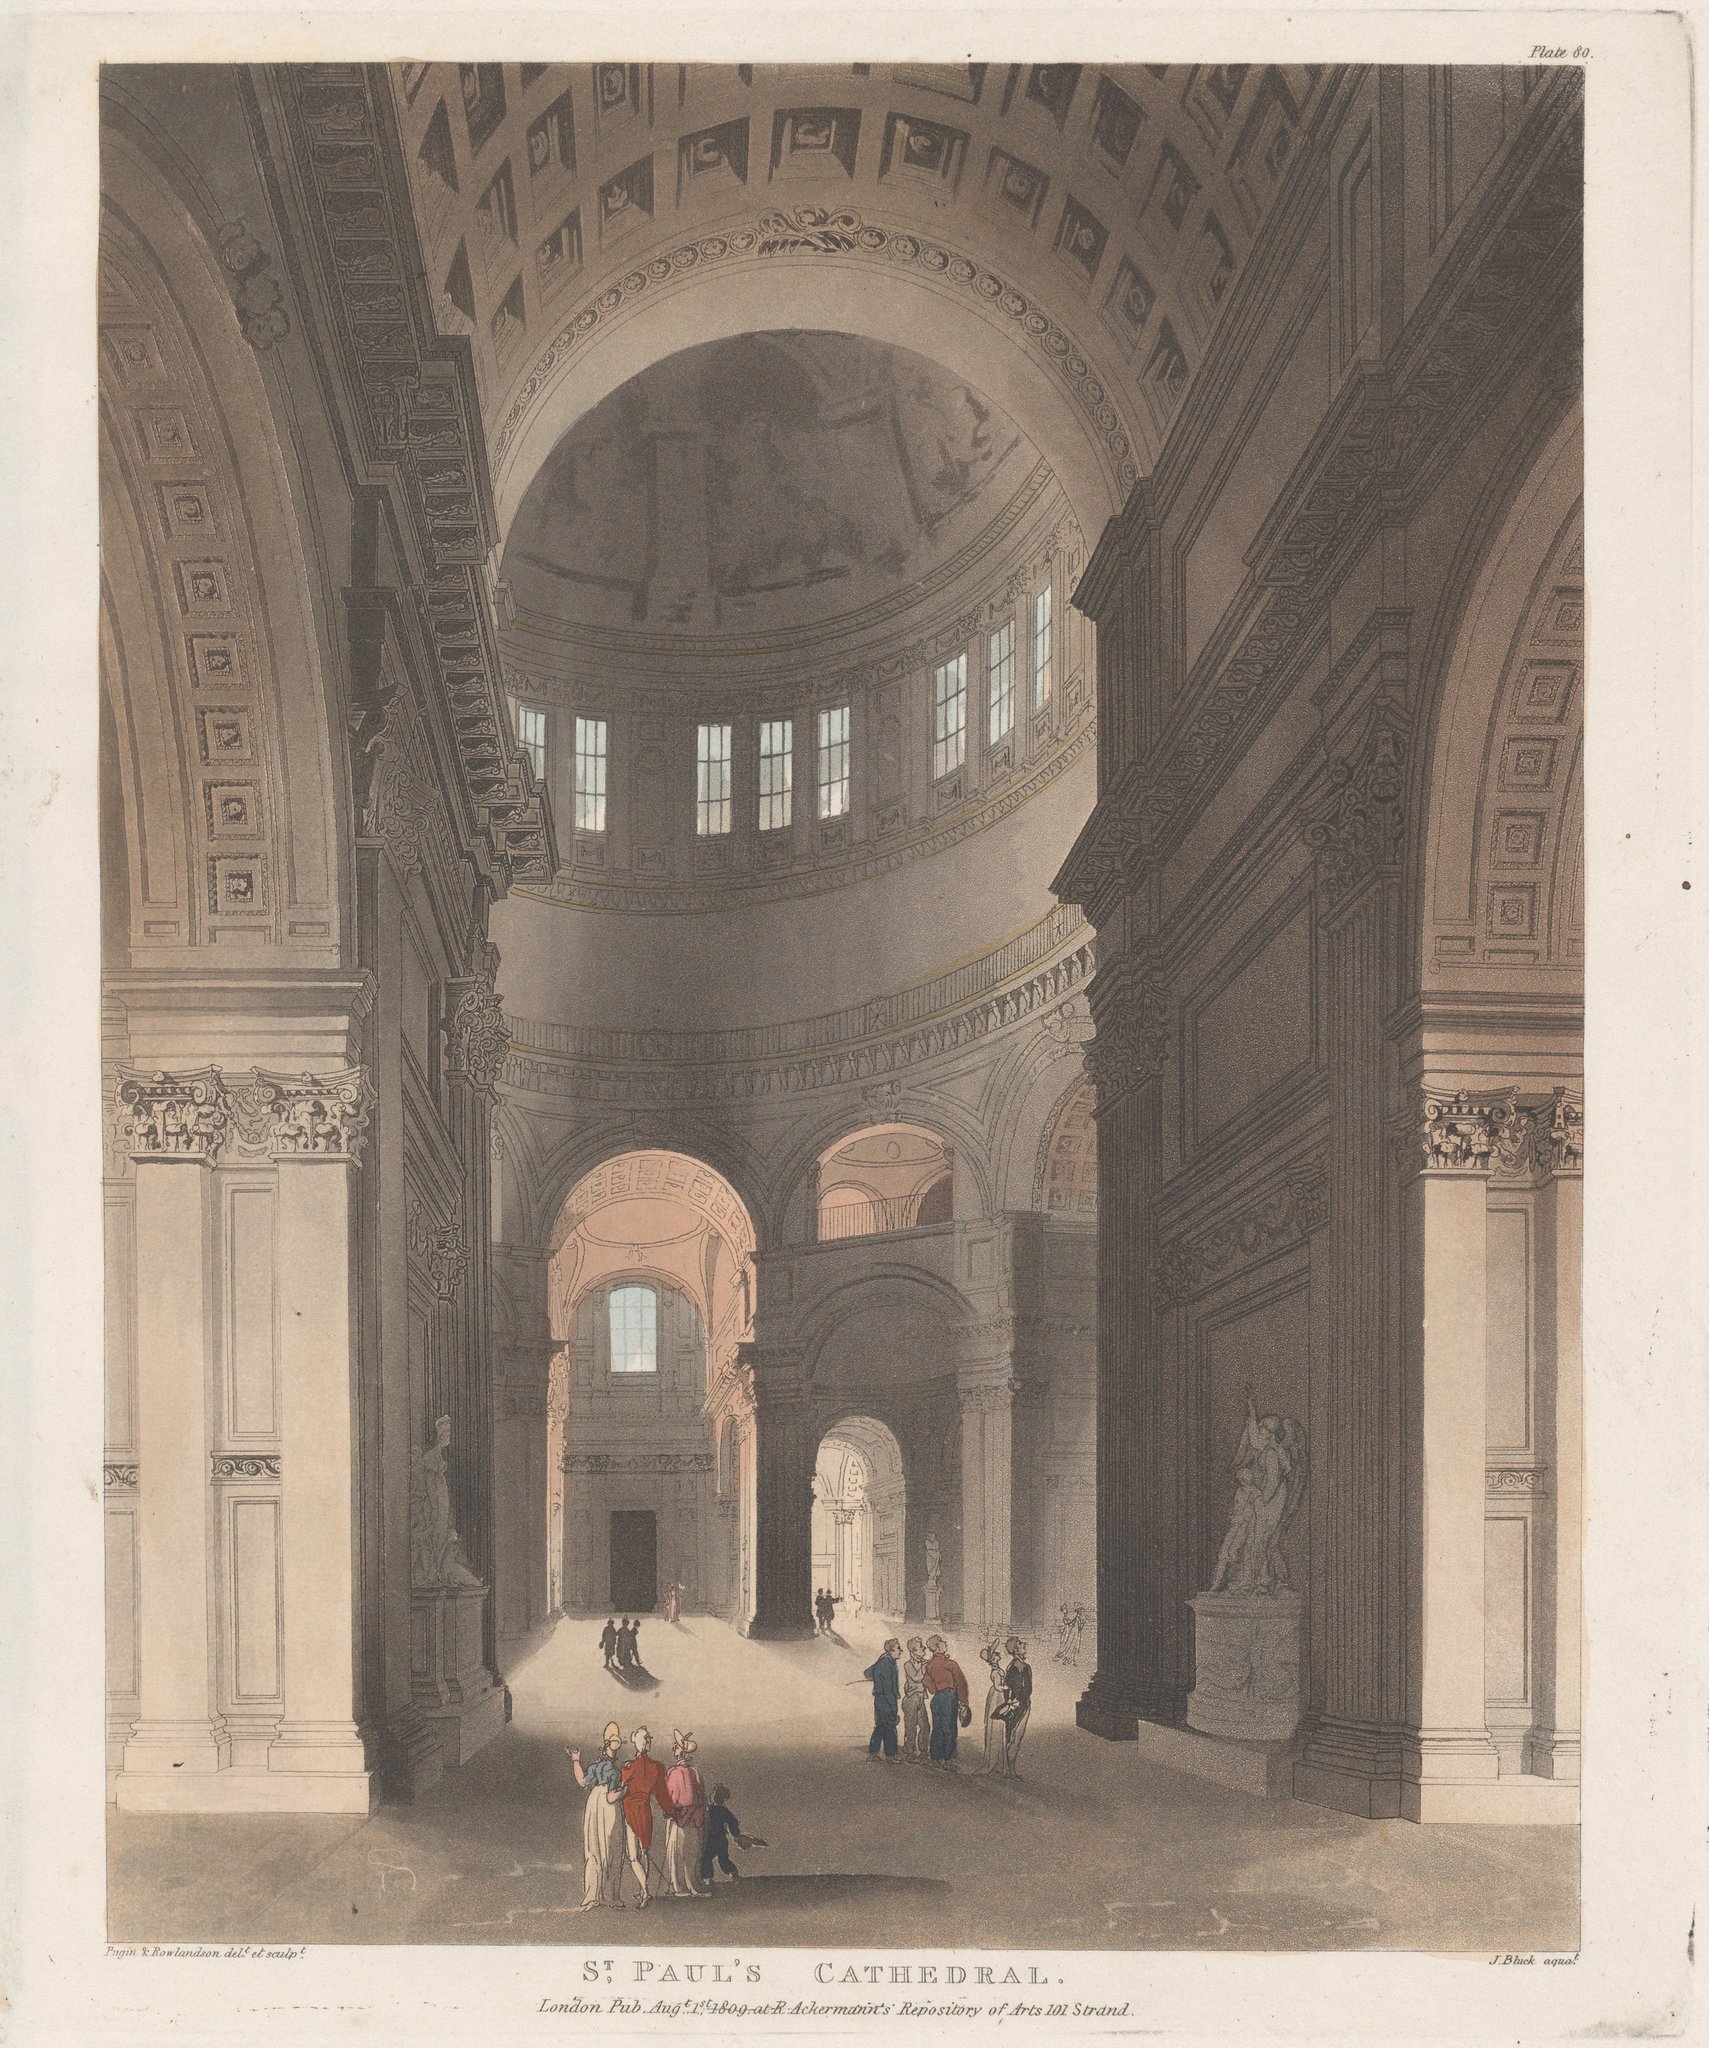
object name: print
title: St. Paul's Cathedral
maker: thomas rowlandson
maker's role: artist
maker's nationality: british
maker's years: 1757-1827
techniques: aquatint, etching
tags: architecture,interiors,cathedrals